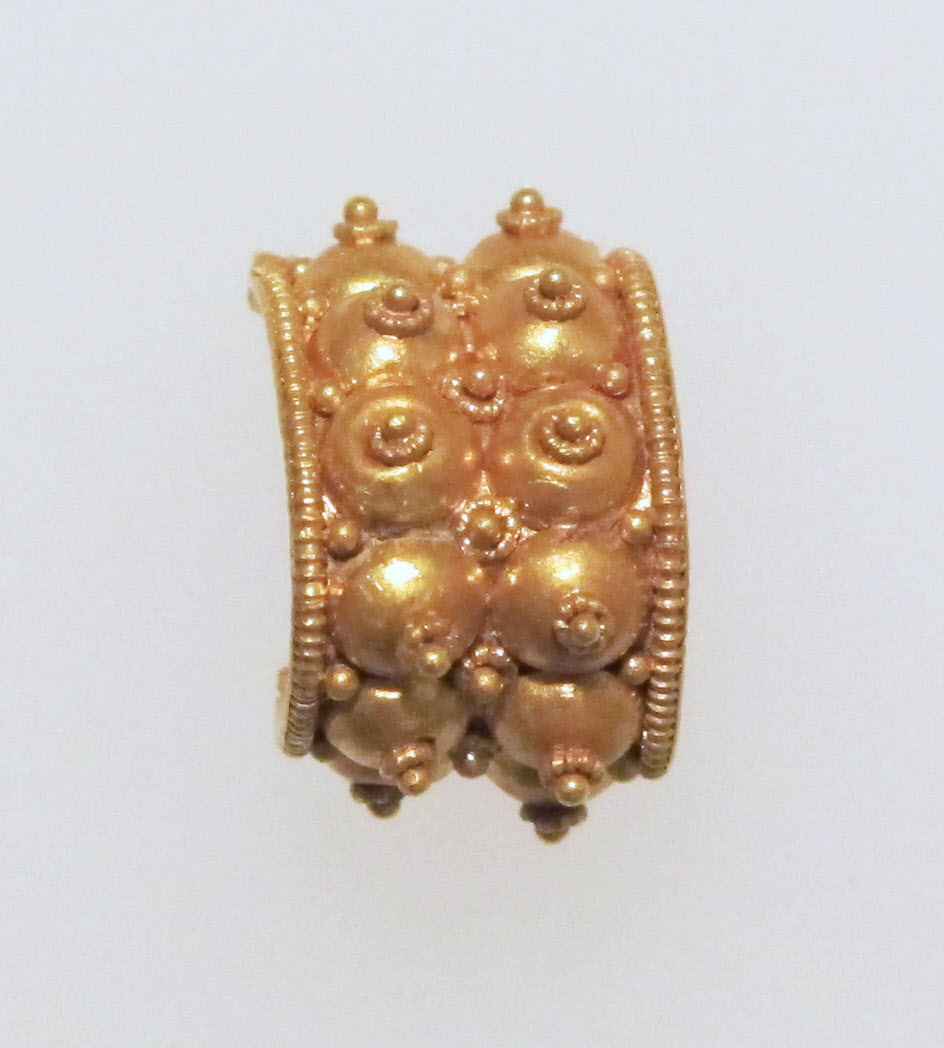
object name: earring, baule type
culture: etruscan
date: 700-401 BCE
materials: gold